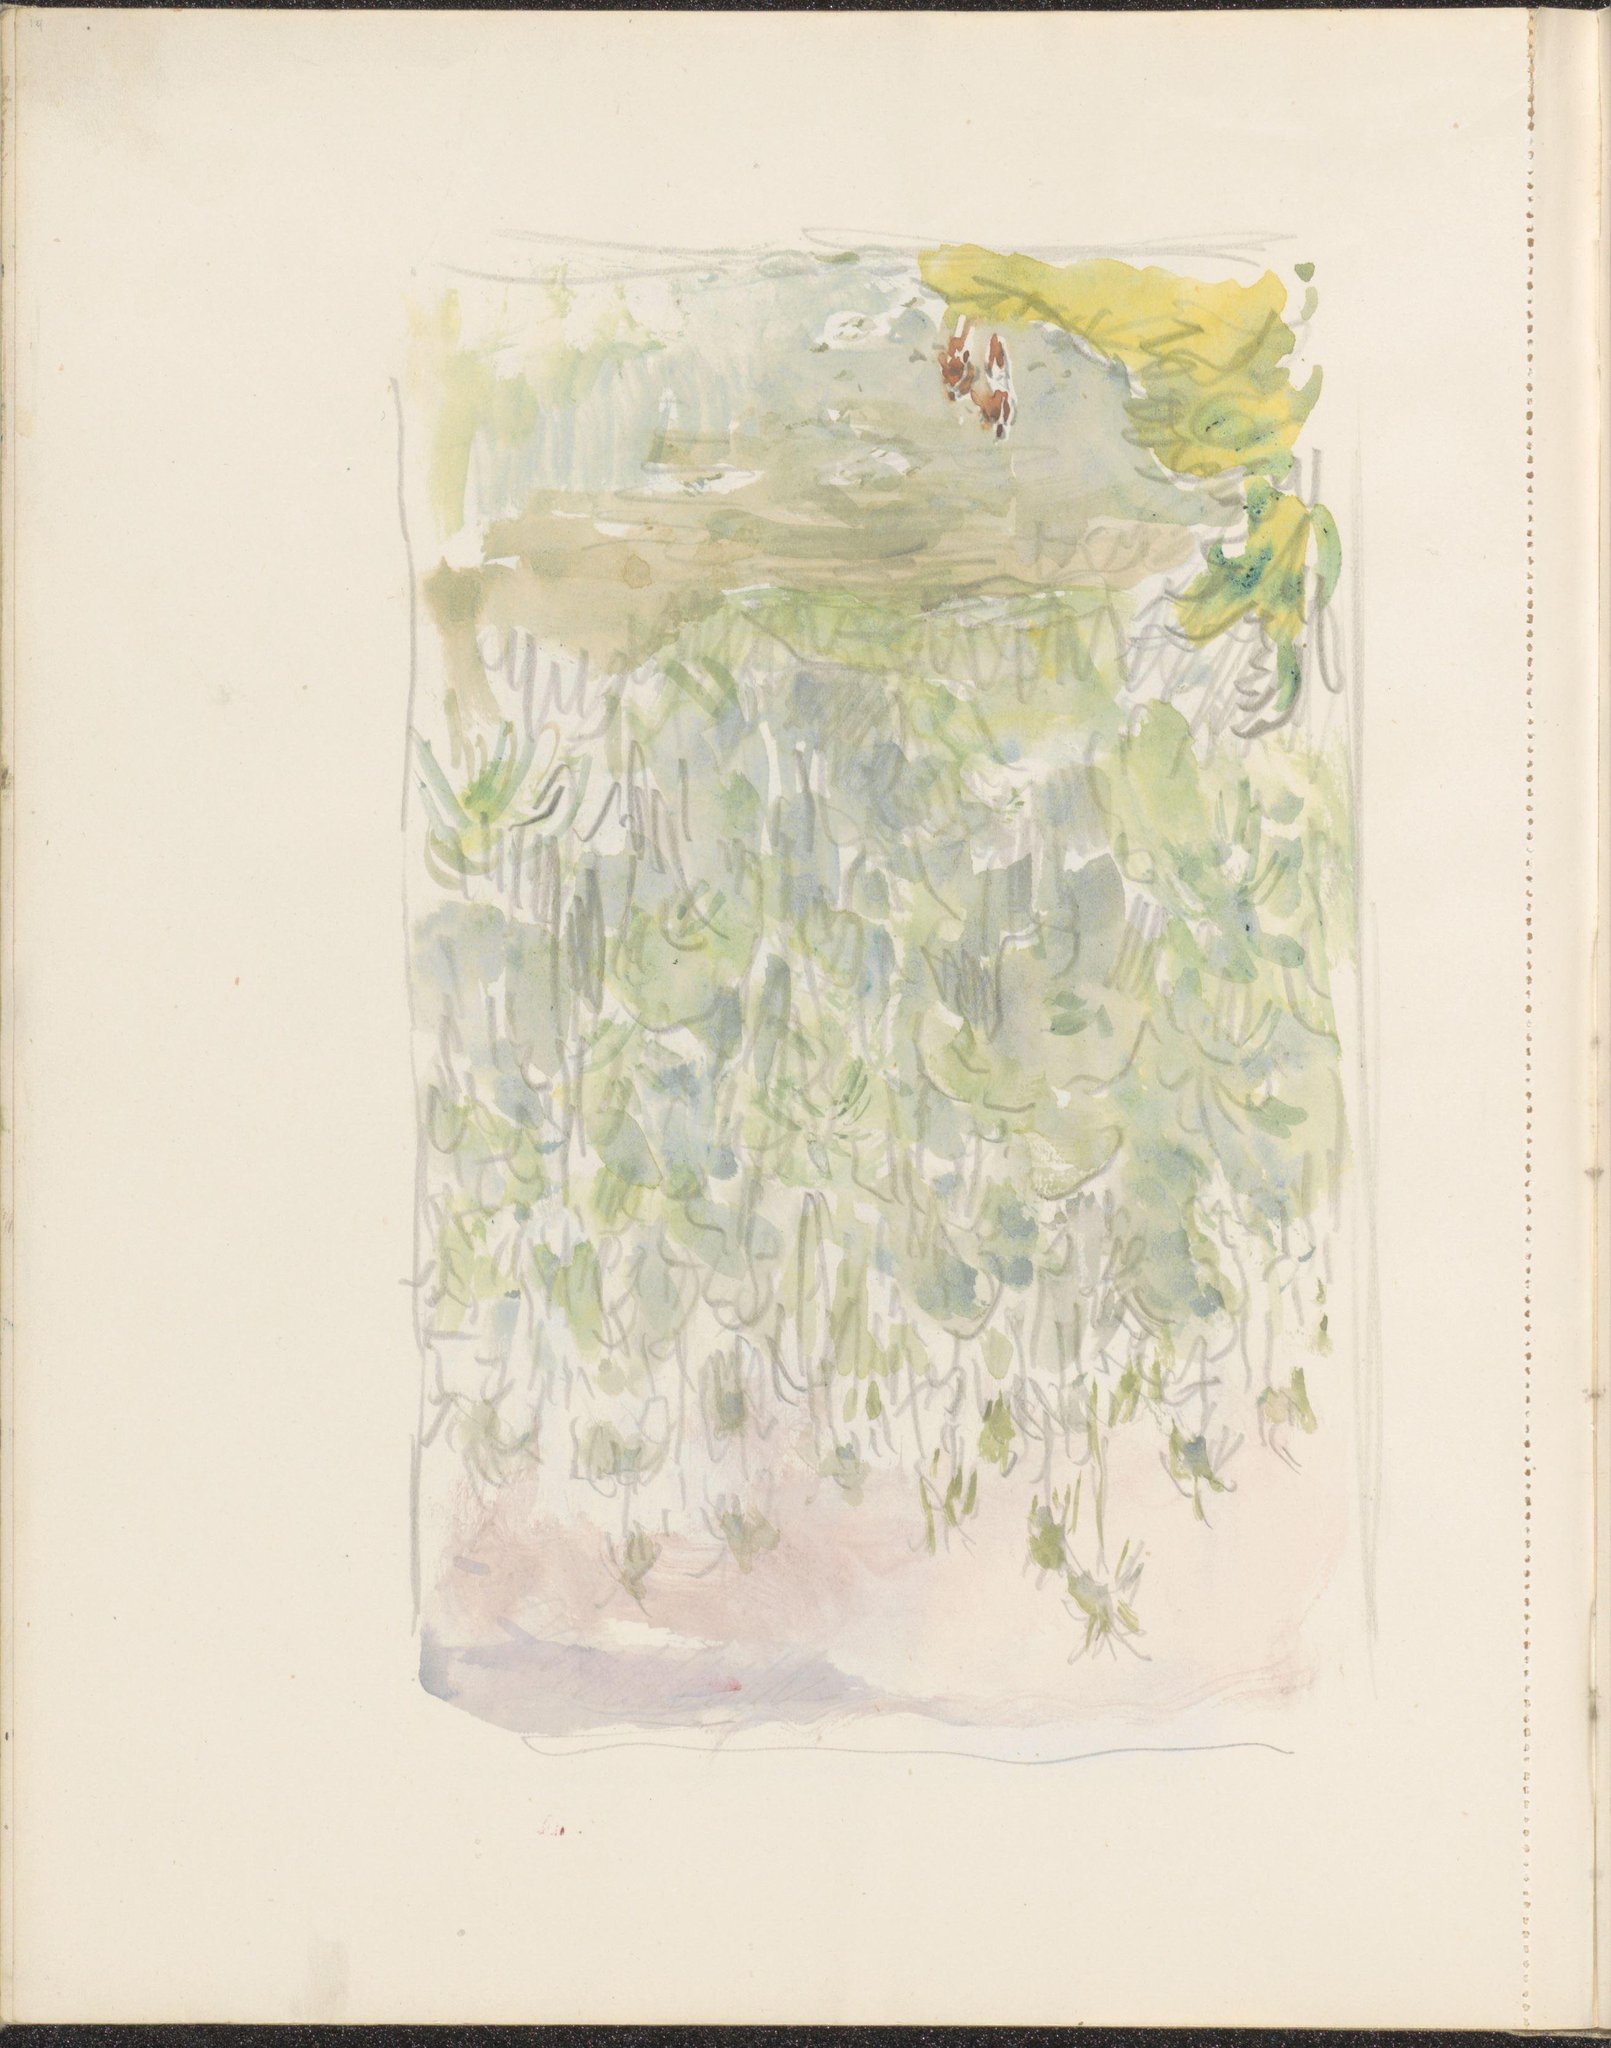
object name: sketchbook leaf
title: Figuren bij de oever van een rivier in het oerwoud van Siam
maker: marius bauer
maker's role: draughtsman, print maker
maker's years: 1867-1932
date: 1931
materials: paper, pencil, watercolor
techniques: brush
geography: thailand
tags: river, jungle, landscapes (+ landscape with figures, staffage)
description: Pagina 14 uit een schetsboek met 48 bladen.